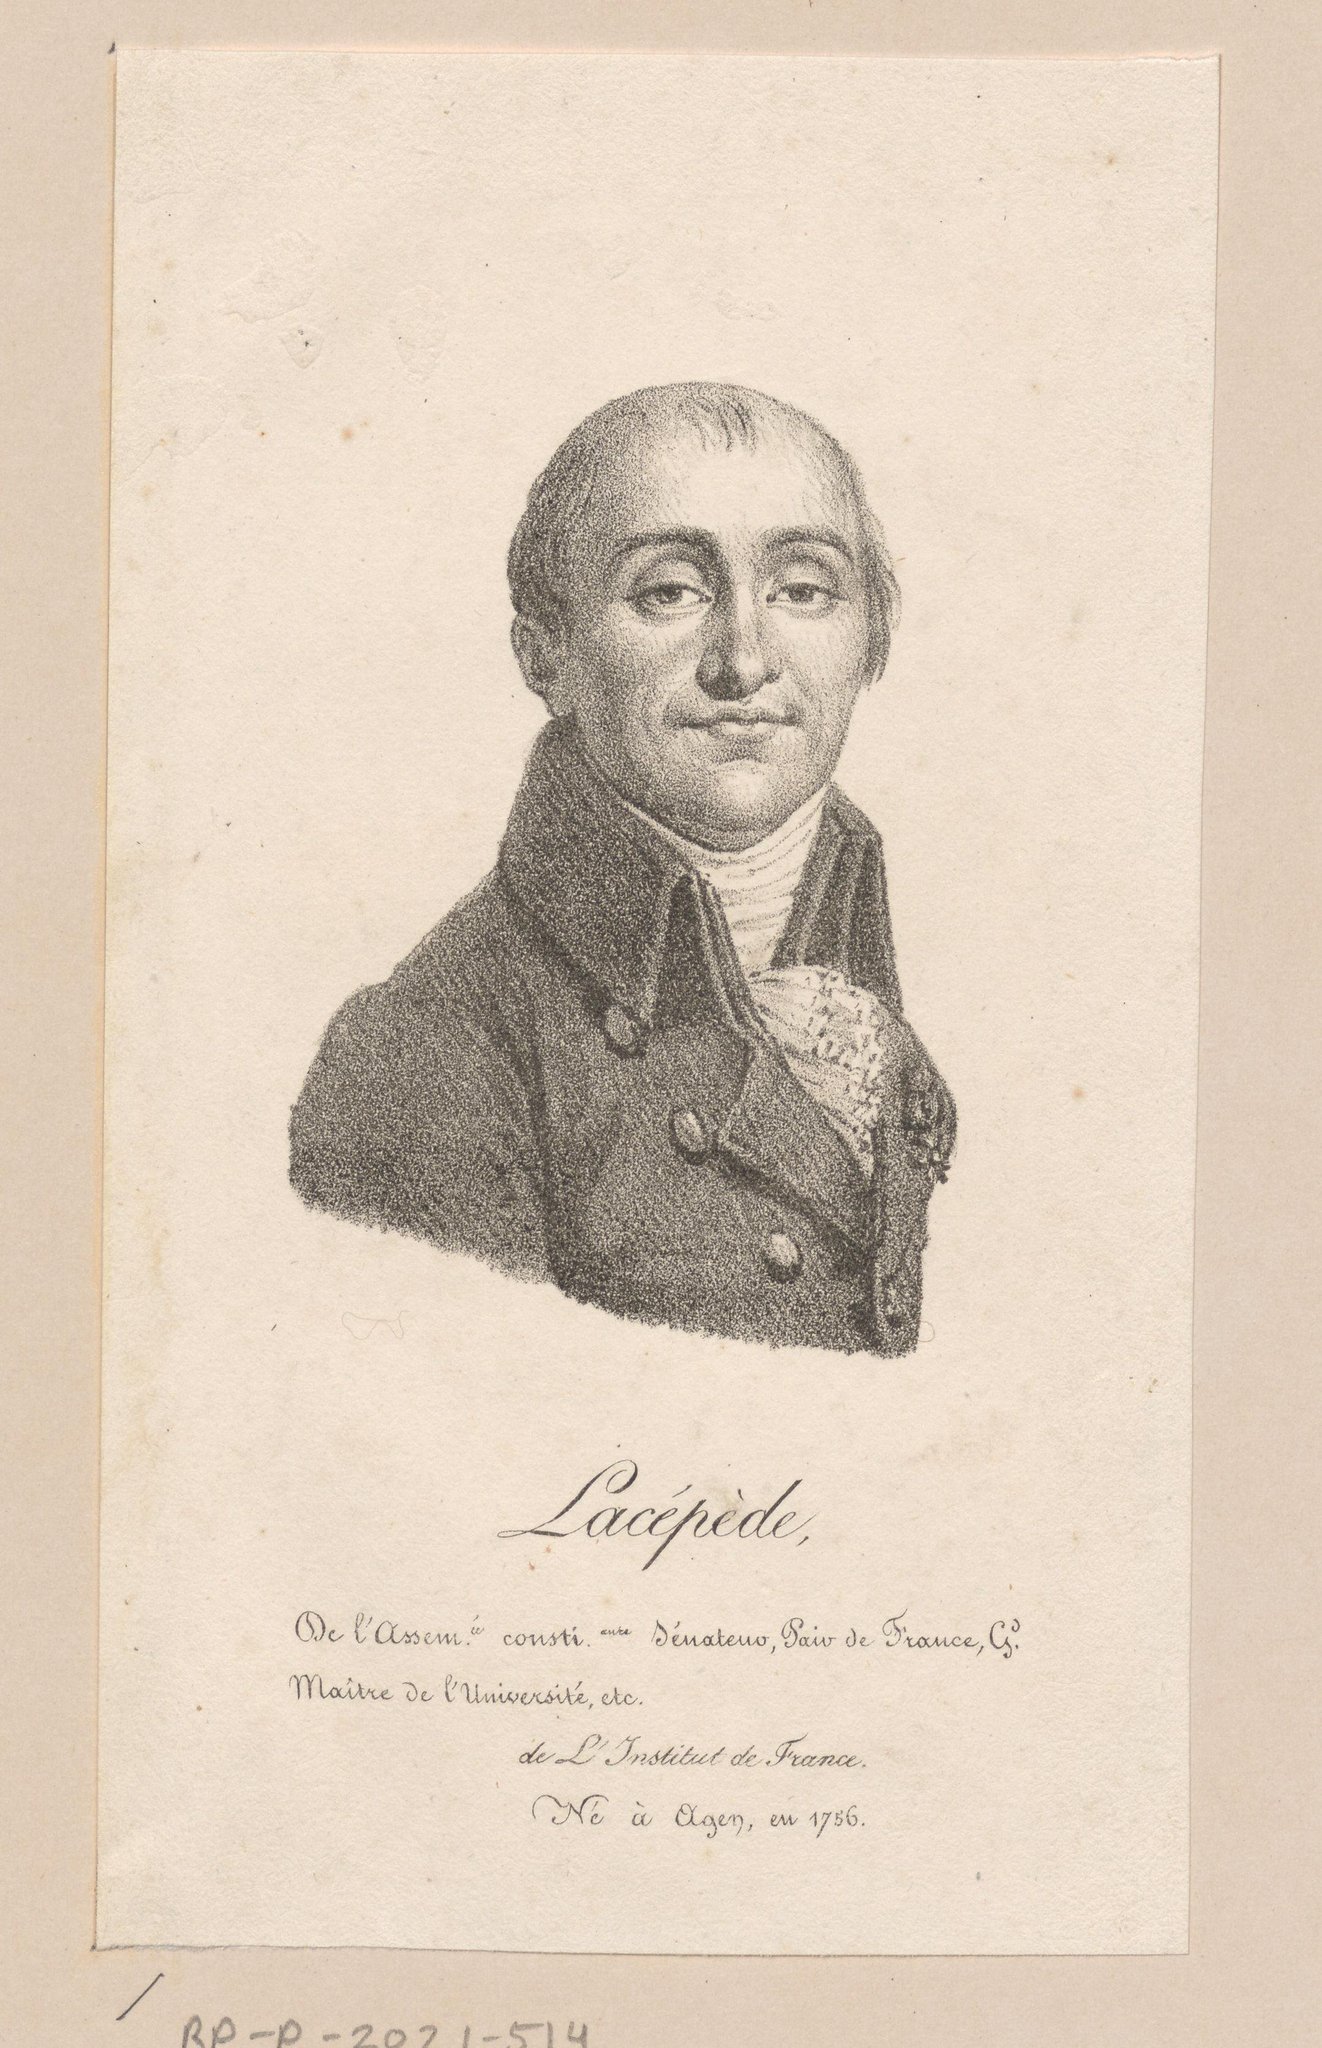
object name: print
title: Portret van Bernard Germain de Lacépède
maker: Anonymous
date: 1814-1825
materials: paper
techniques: lithograph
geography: france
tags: politician, historical persons, politician, e.g. party leader